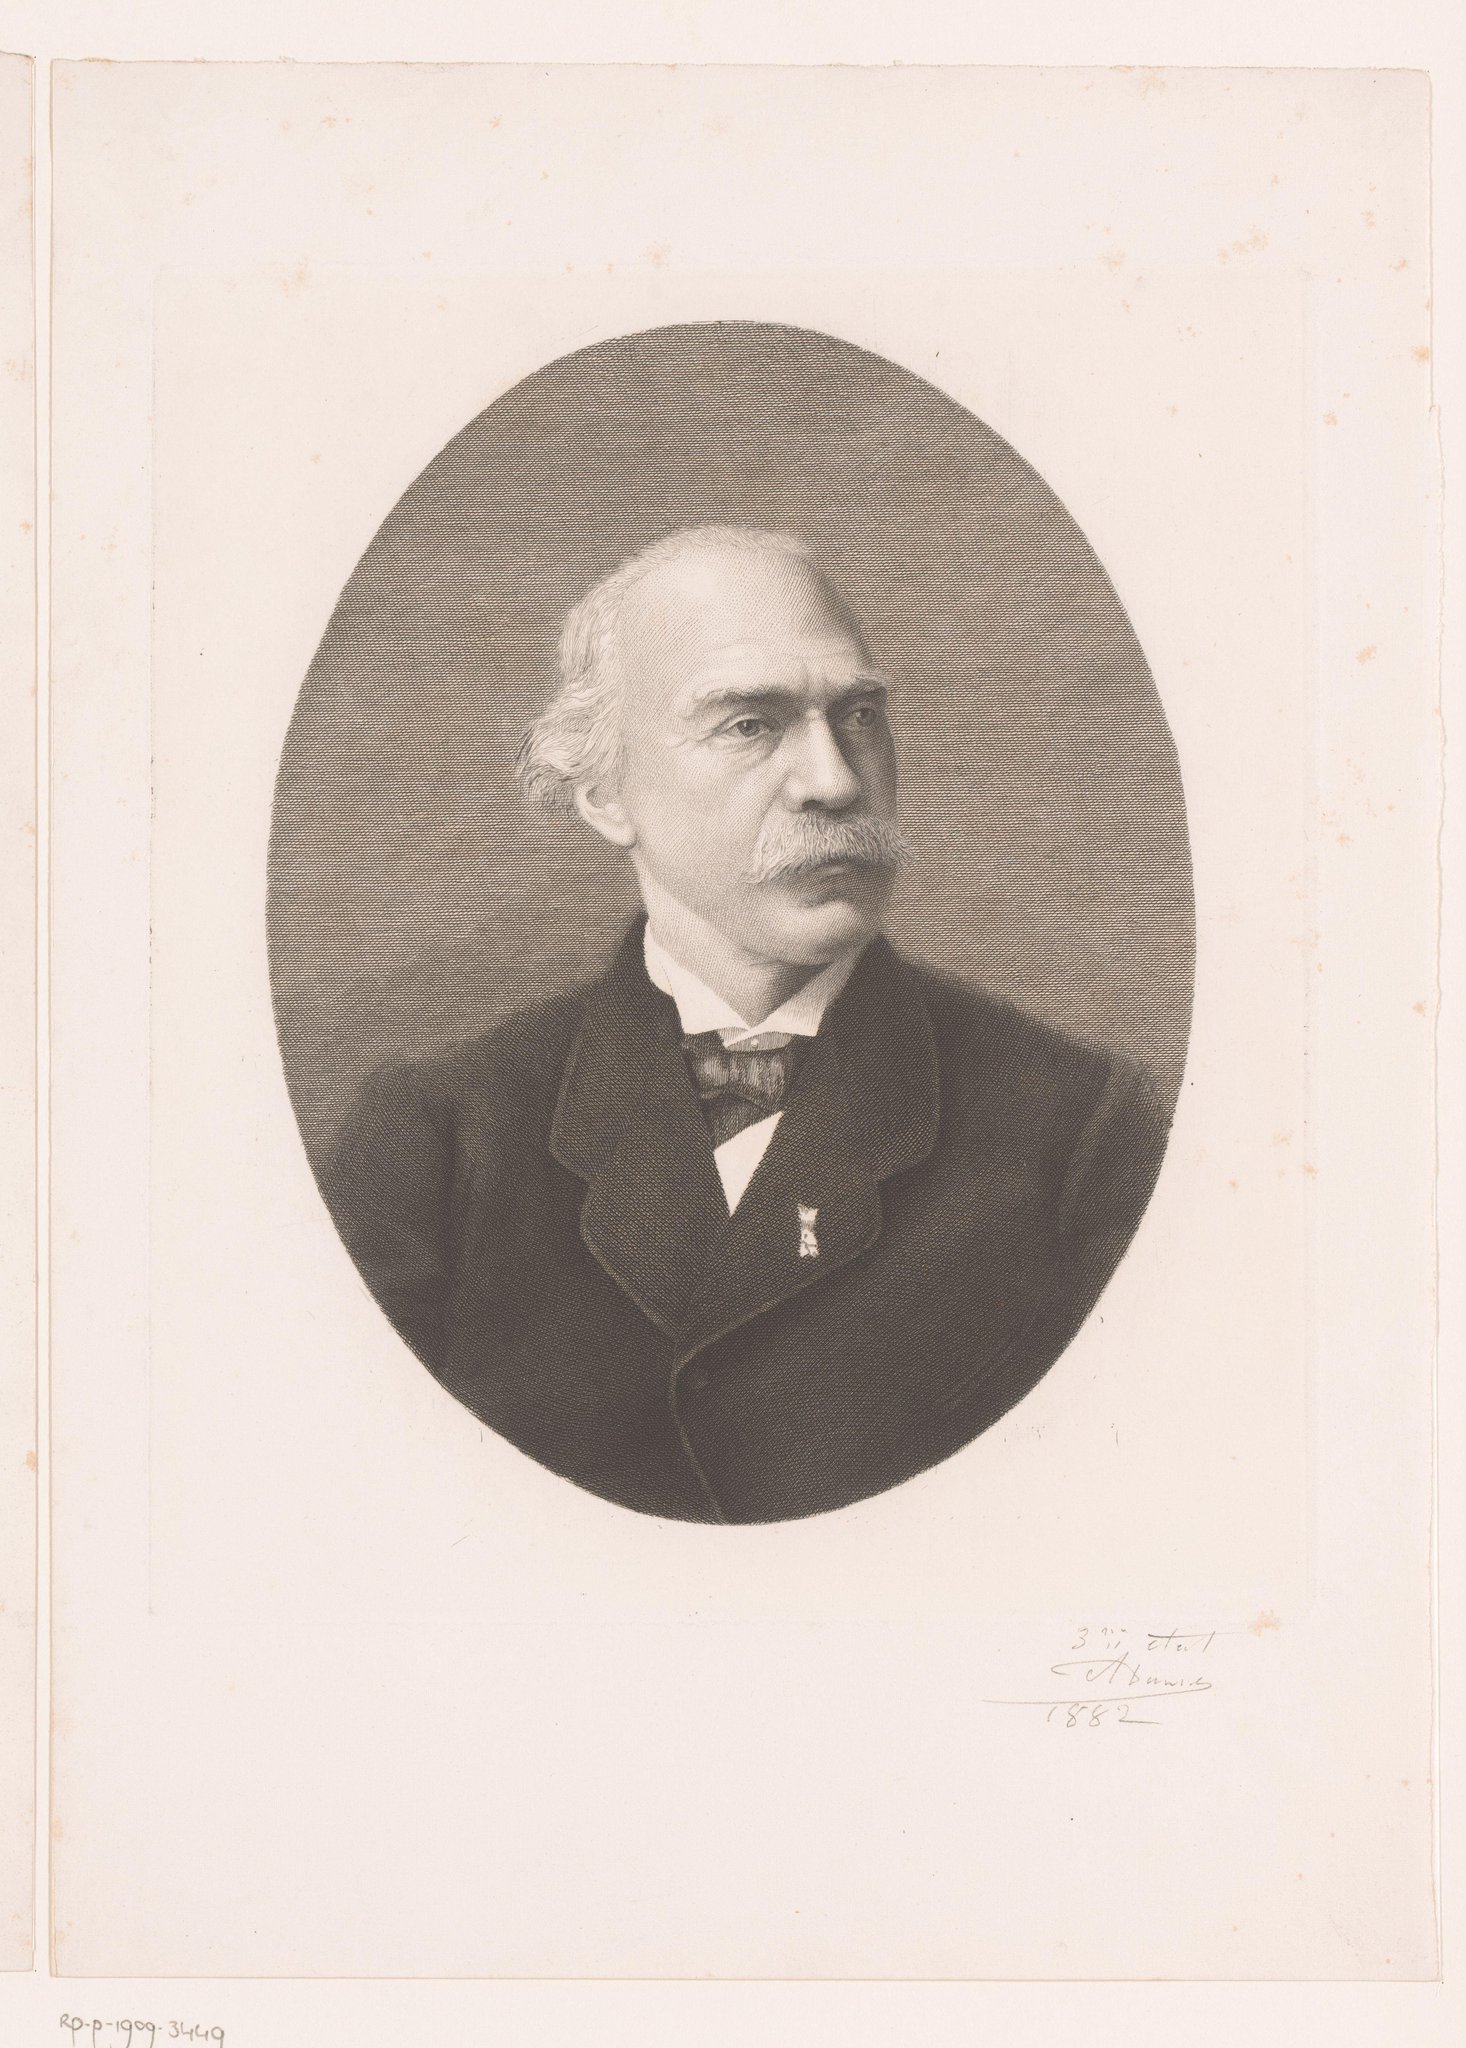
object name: print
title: Portret van een onbekende man, mogelijk Boulez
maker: auguste danse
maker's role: print maker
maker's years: 1829-1929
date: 1882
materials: paper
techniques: etching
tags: anonymous historical person portrayed alone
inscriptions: collector's mark: Lugt 2228, annotation: ‘3me état’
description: De identificatie Boulez is overgenomen van een handgeschreven aantekening op een ander exemplaar in de collectie van het Rijksmuseum Amsterdam.